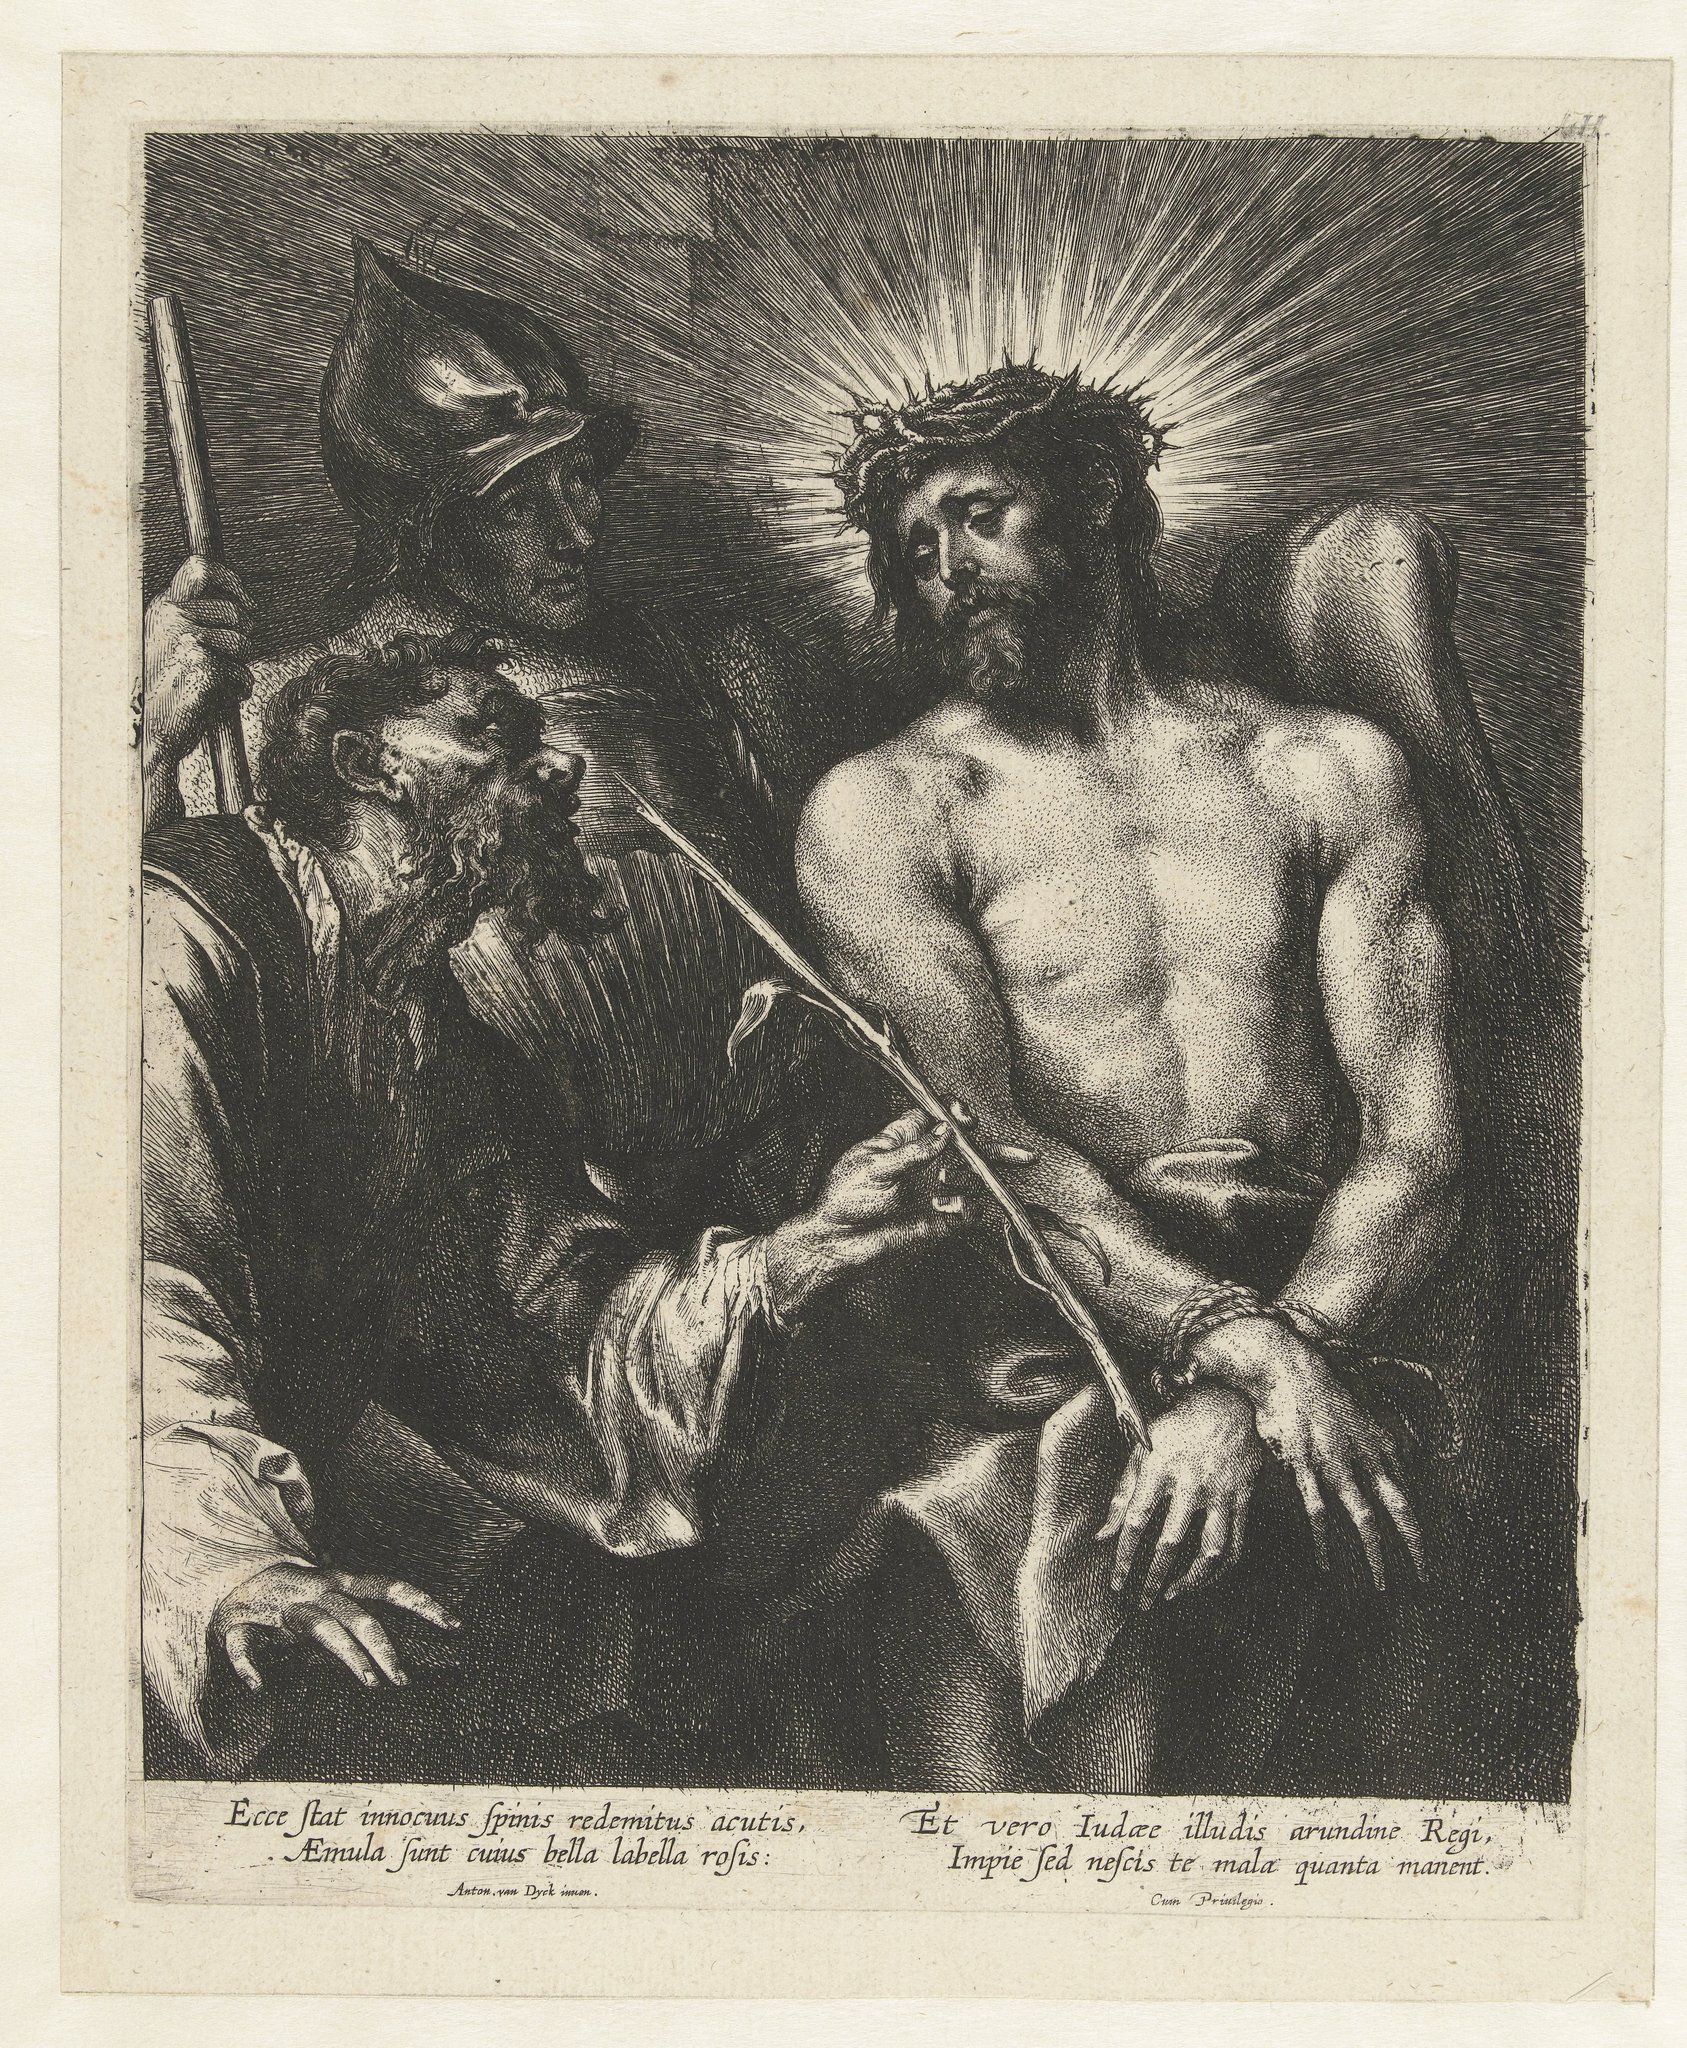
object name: print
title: De bespotting van Christus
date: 1630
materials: paper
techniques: engraving, etching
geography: antwerp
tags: mockings of christ, who may be blindfolded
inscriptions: monogram: ‘GH’, collector's mark: Lugt 240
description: De bespotting van Christus door twee mannen, een man reikt hem spottend de rietstaf aan en een soldaat hangt hem een mantel om de schouders. Met vier regels Latijnse tekst in de marge onderaan.